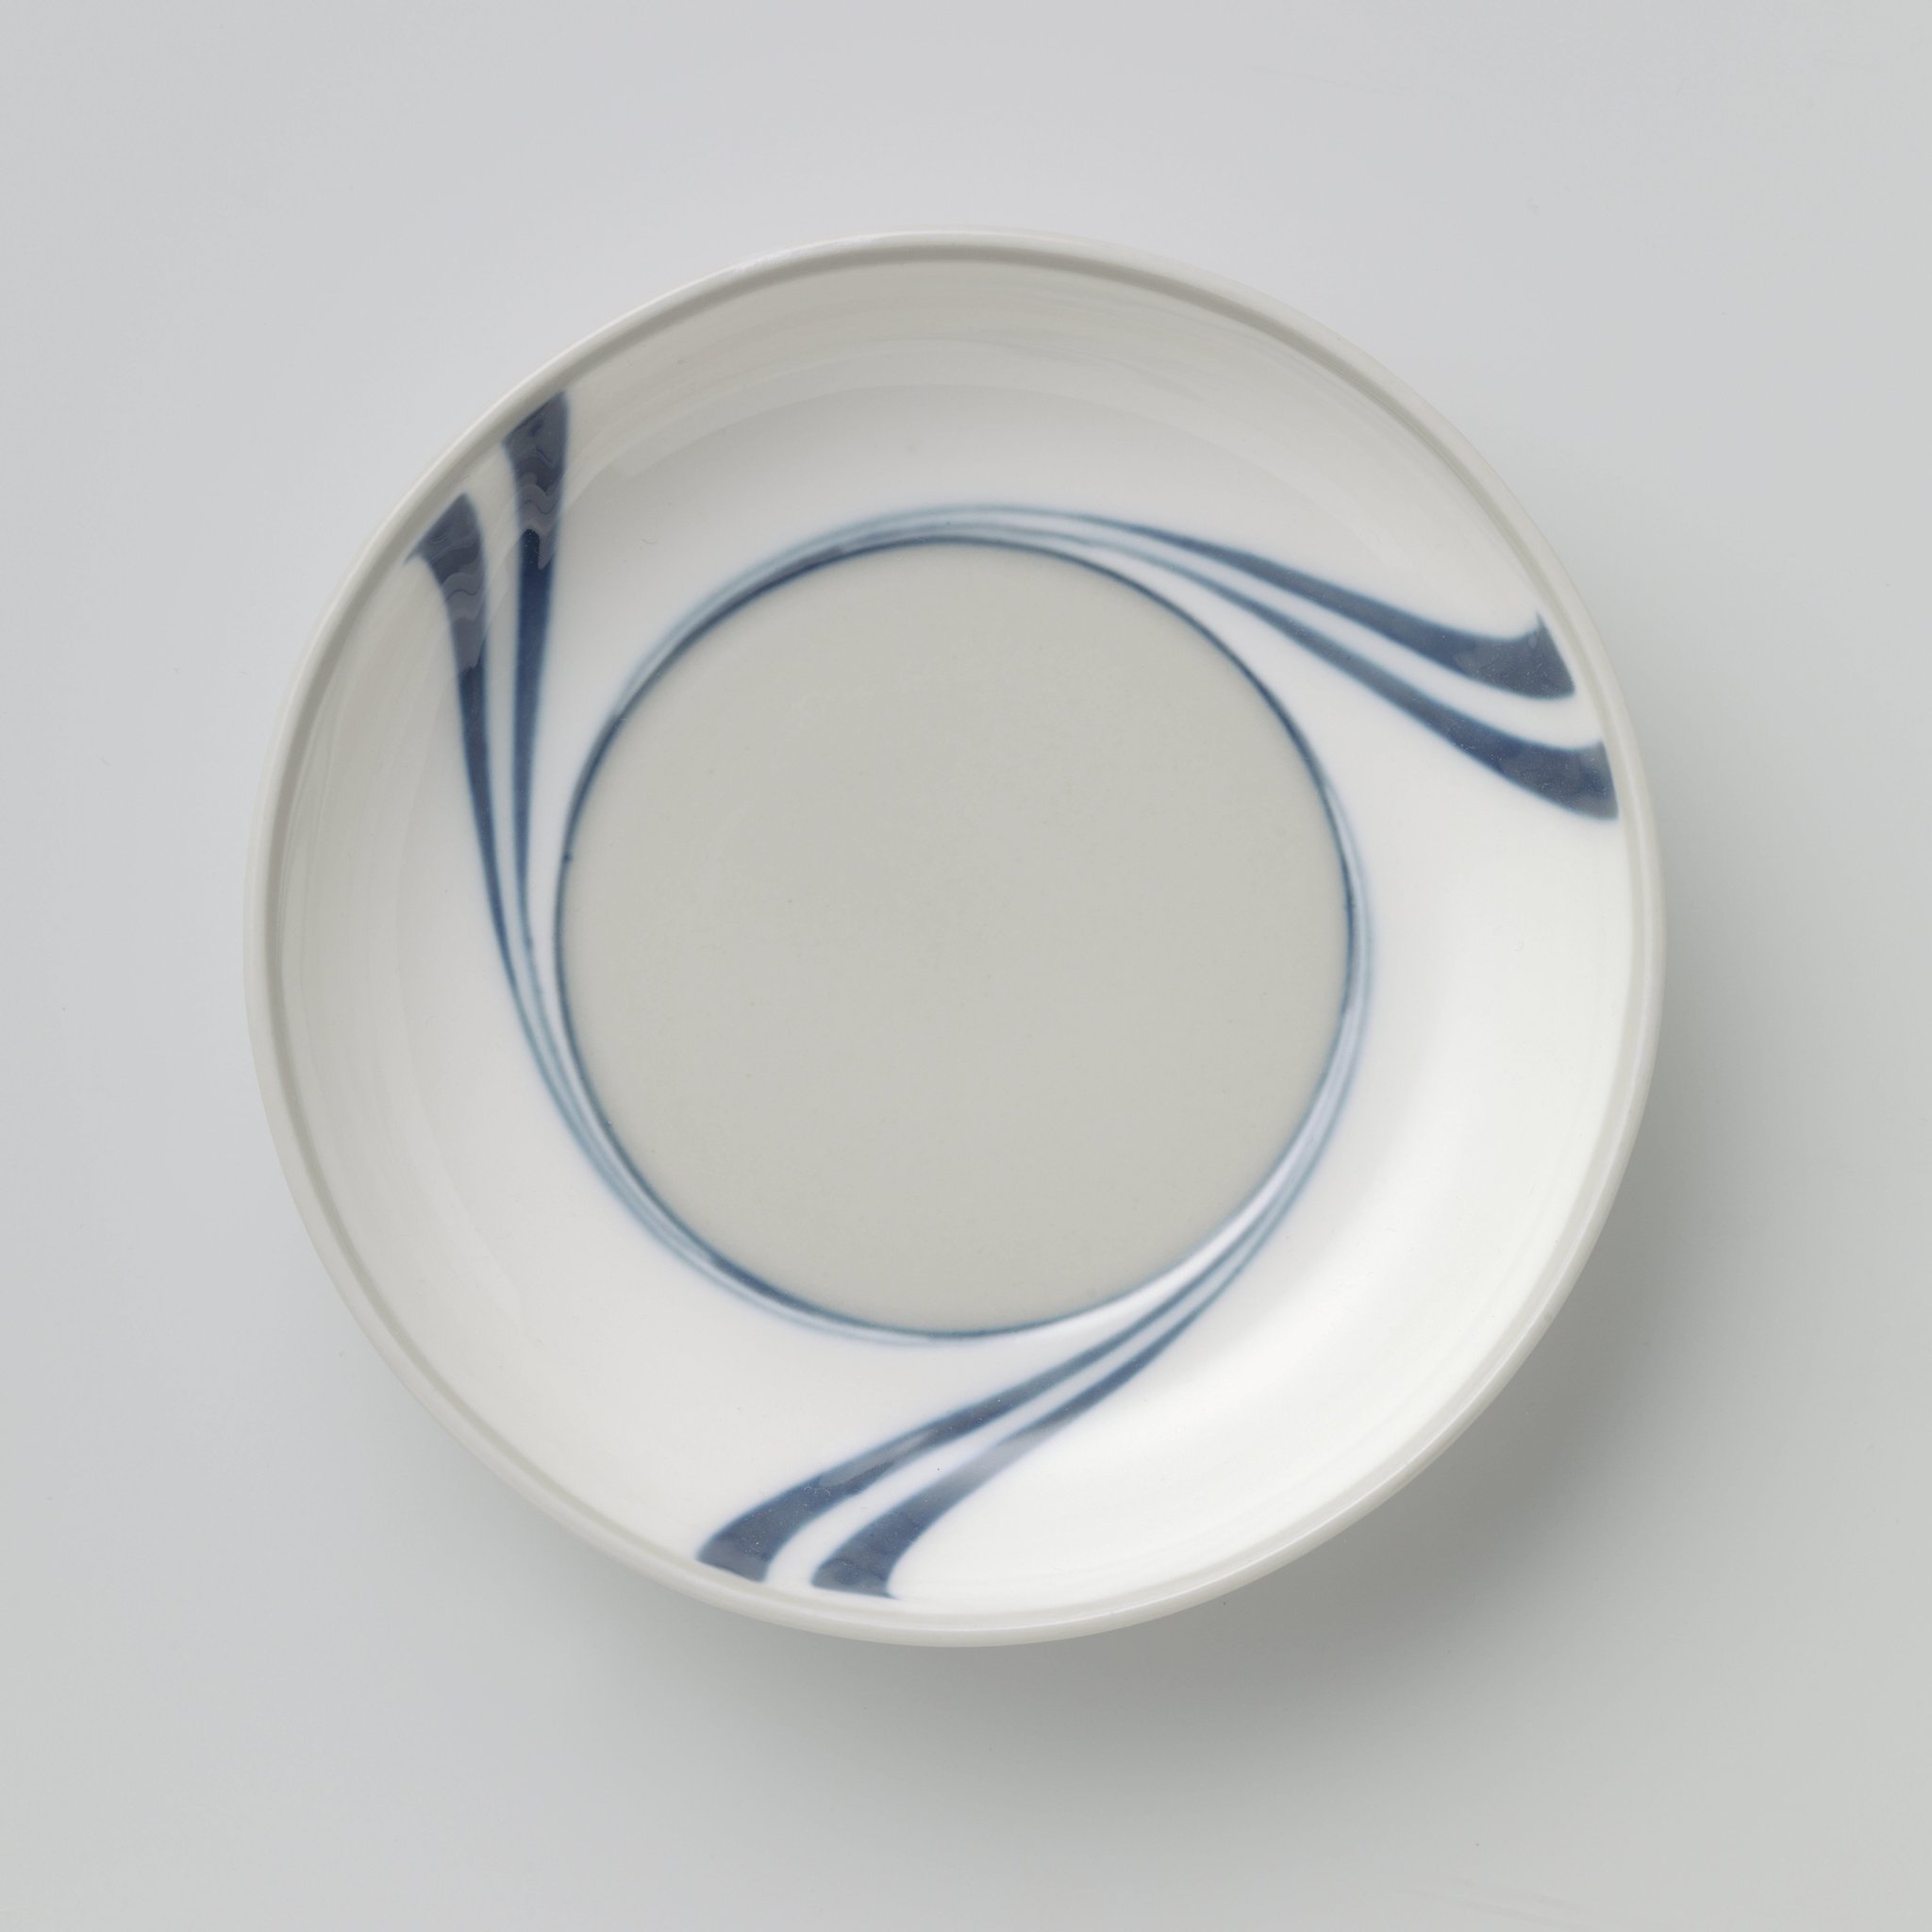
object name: platter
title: Schotel uit het koffie- en theeservies 'Saxonia'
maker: otto eduard voigt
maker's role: keramiekontwerper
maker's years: 1870-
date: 1904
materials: porcelain, chemical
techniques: painted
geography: meissen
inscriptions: mark: ‘66 (of 99)’, factory mark, model number: ‘U 127’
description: Schotel van porselein, beschilderd in blauw en grijs. De schotel hoort bij het koffie- en theeservies Saxonia. De schotel is gemerkt.